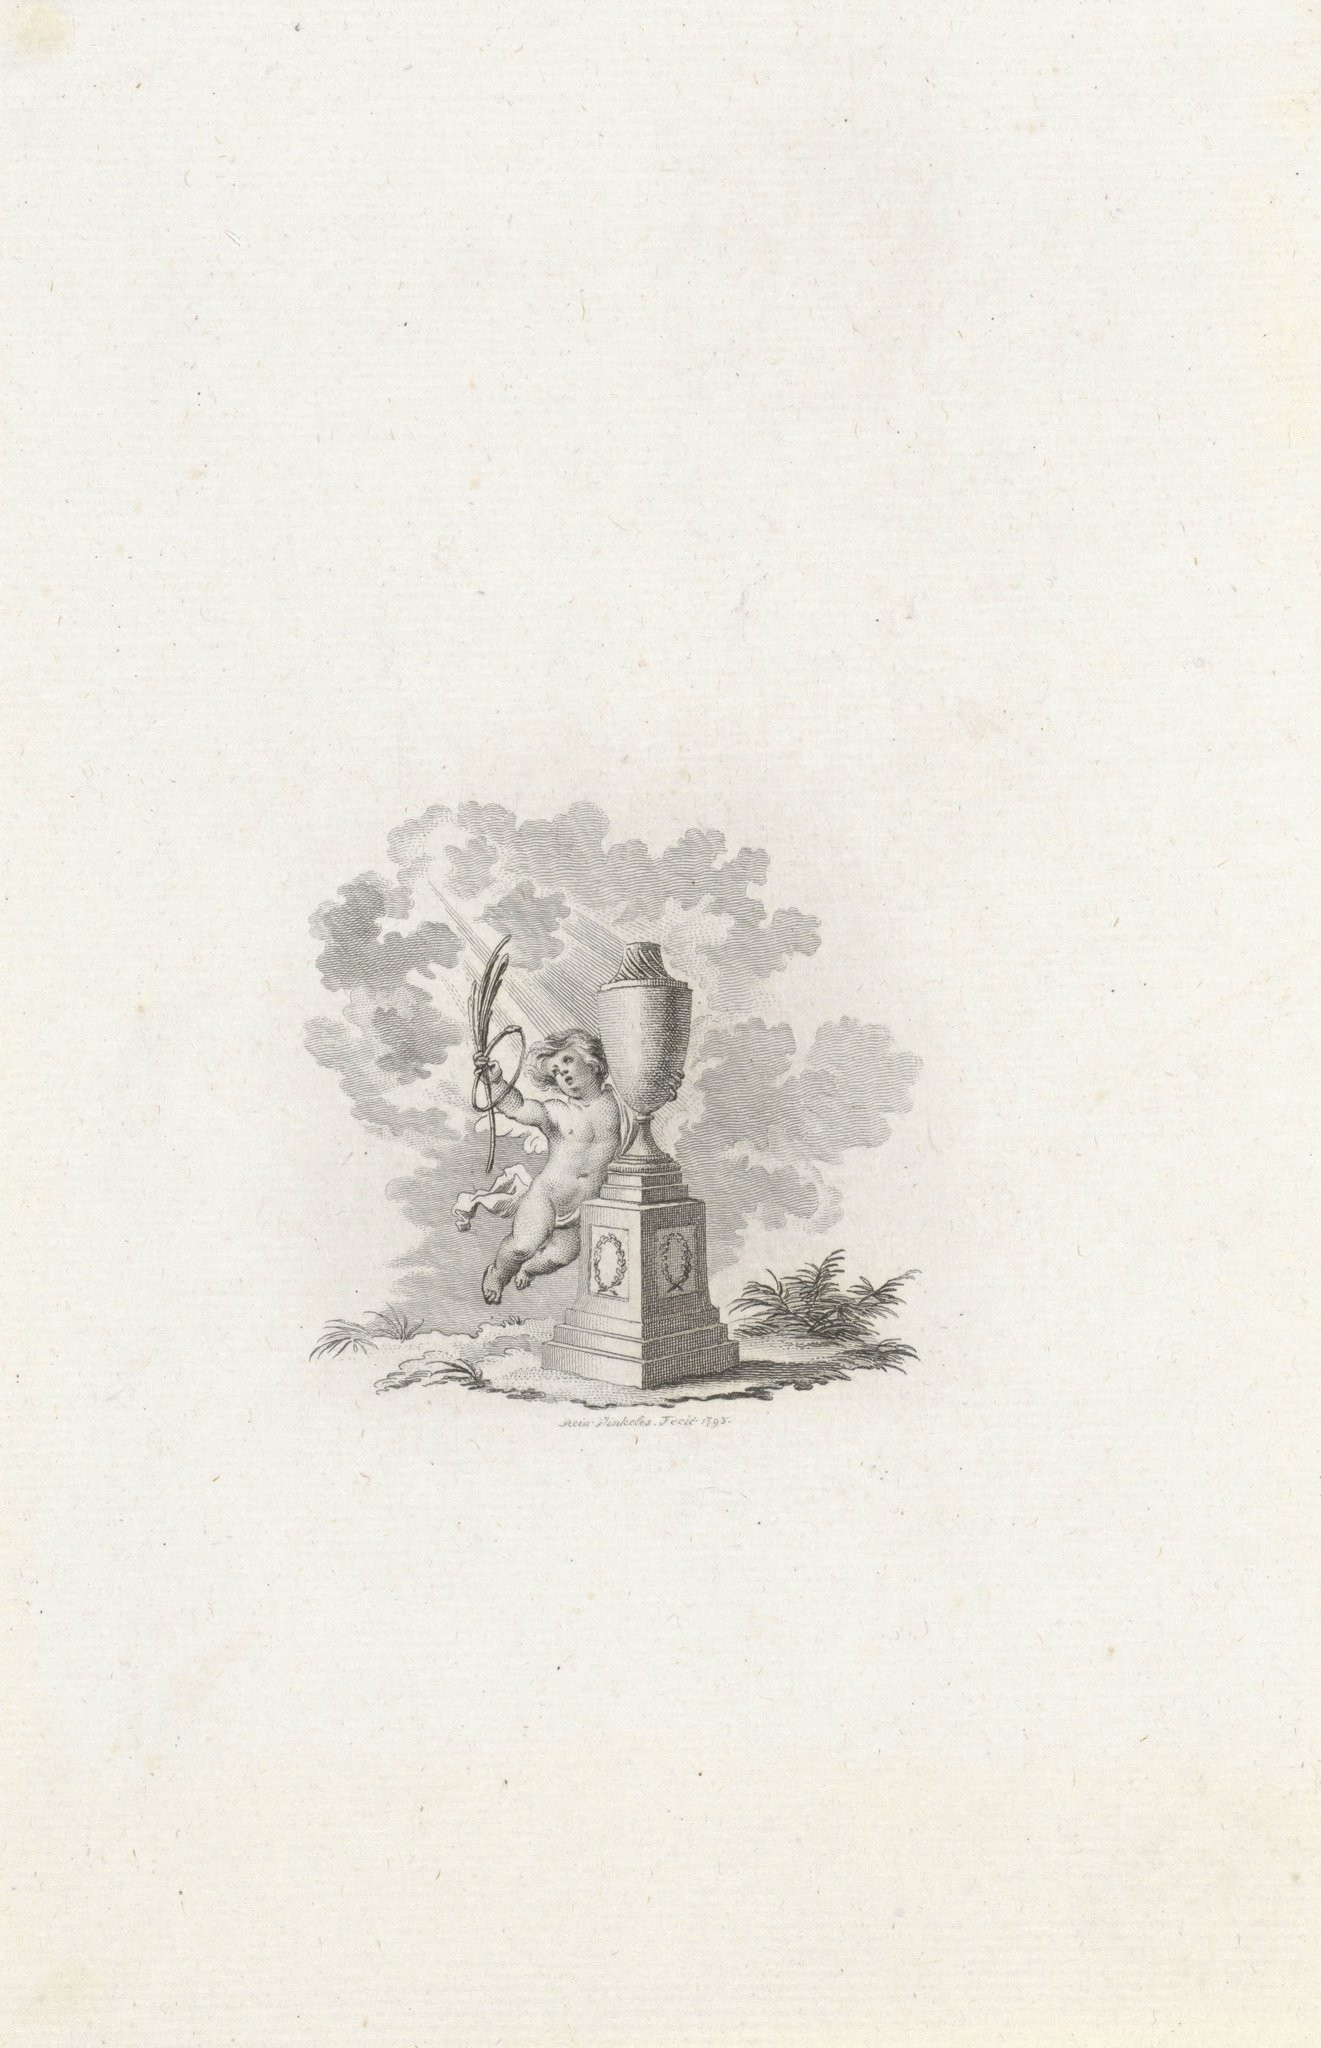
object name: print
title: Vignet met putto met palmtak bij een vaas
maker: reinier vinkeles (i)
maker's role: draughtsman, print maker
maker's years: 1741-1816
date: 1795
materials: paper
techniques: etching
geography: amsterdam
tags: serpent ouroboros, cupids: 'amores', 'amoretti', 'putti'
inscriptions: collector's mark: Lugt 240